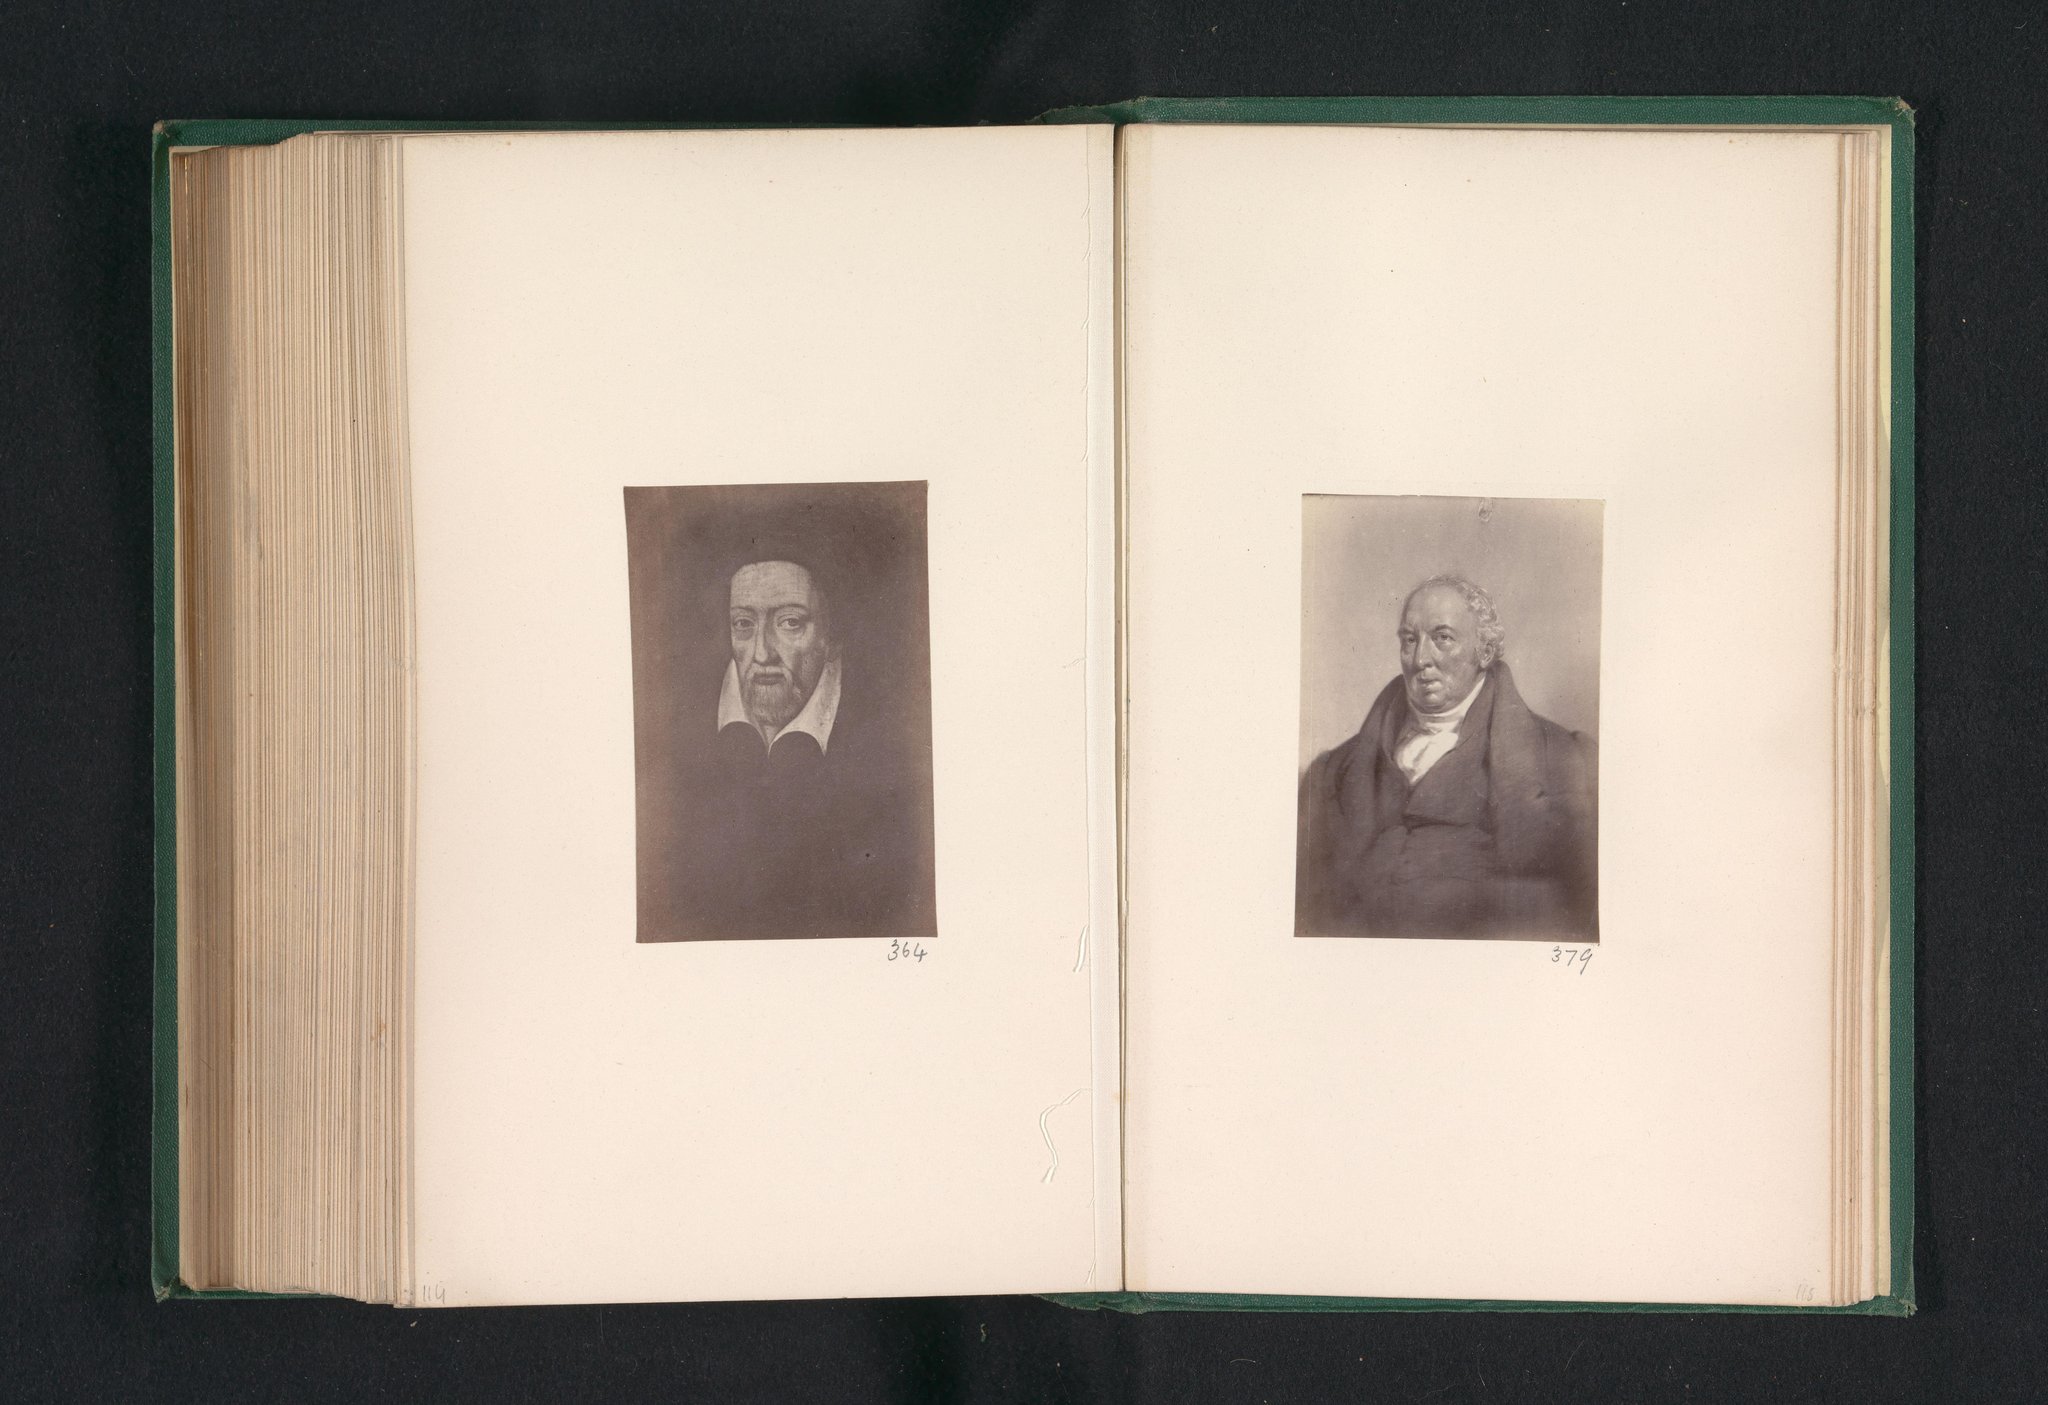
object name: page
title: Fotoreproductie van een schilderij, voorstellende een portret van Samuel Hunter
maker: thomas annan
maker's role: fotograaf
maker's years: 1829-1887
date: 1863-1868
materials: photographic support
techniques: albumen print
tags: historical persons (portraits and scenes from the life) (+ (full) bust portrait)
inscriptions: number: ‘379’